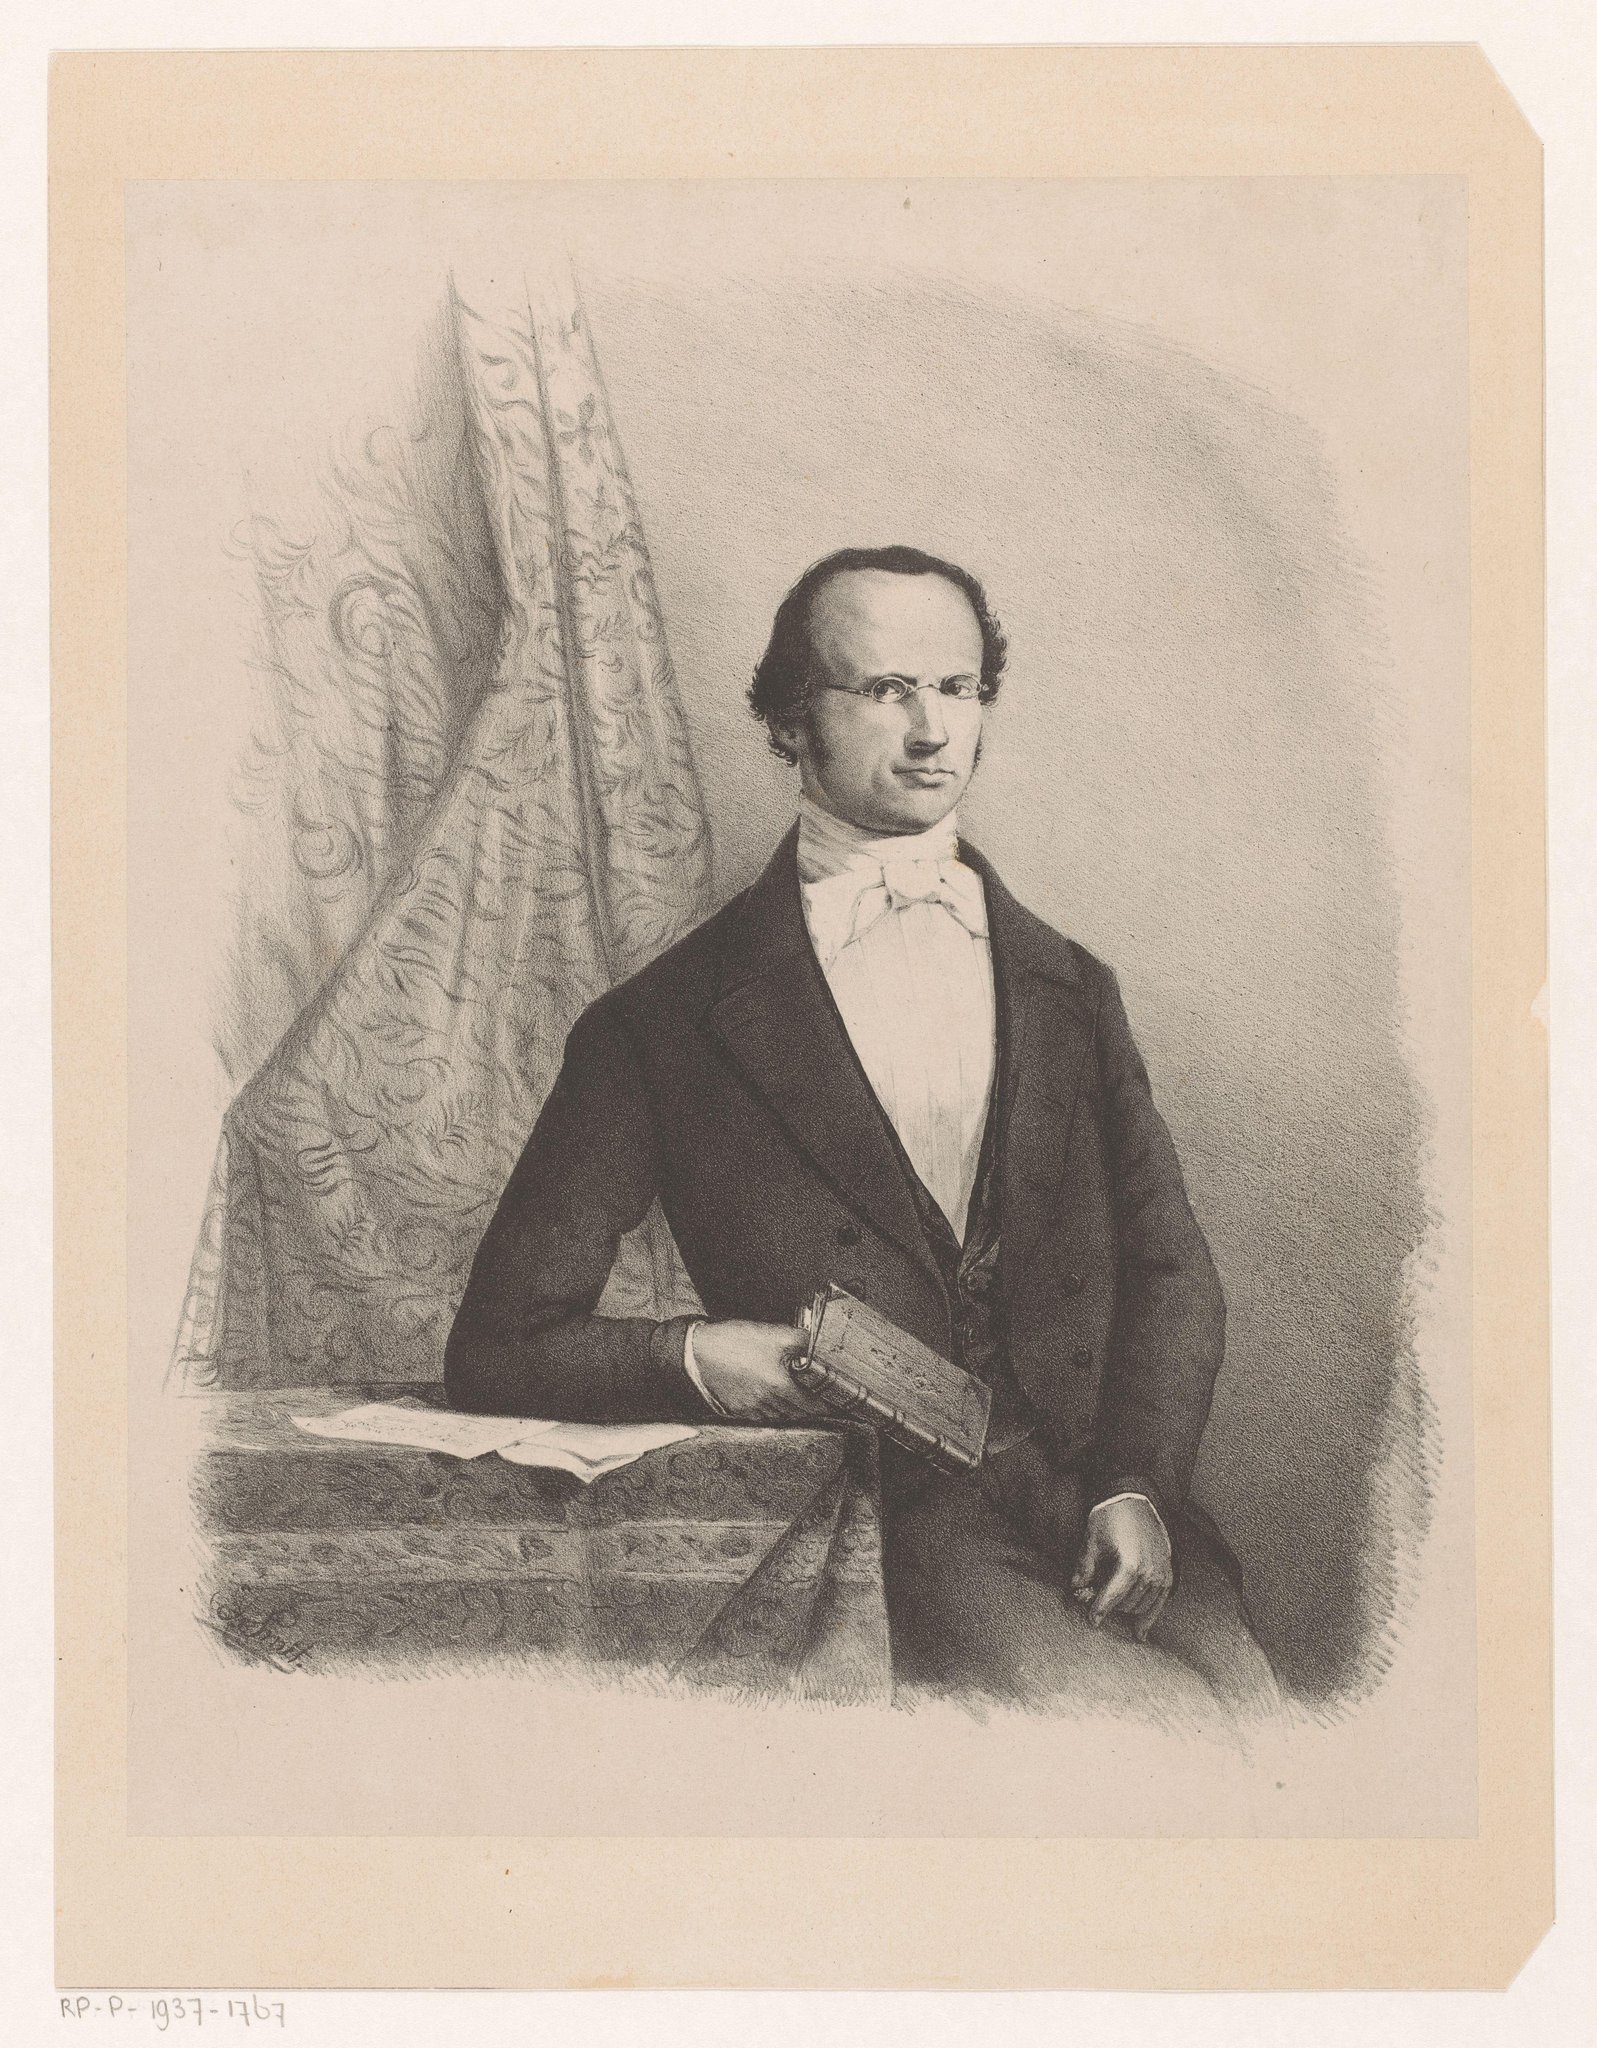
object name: print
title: Portret van Antonie Niermeijer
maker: johannes smit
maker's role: print maker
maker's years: 1805-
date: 1855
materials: paper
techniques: lithograph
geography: netherlands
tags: leiden, historical persons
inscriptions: collector's mark: Lugt 2228, collector's mark: Lugt 2760